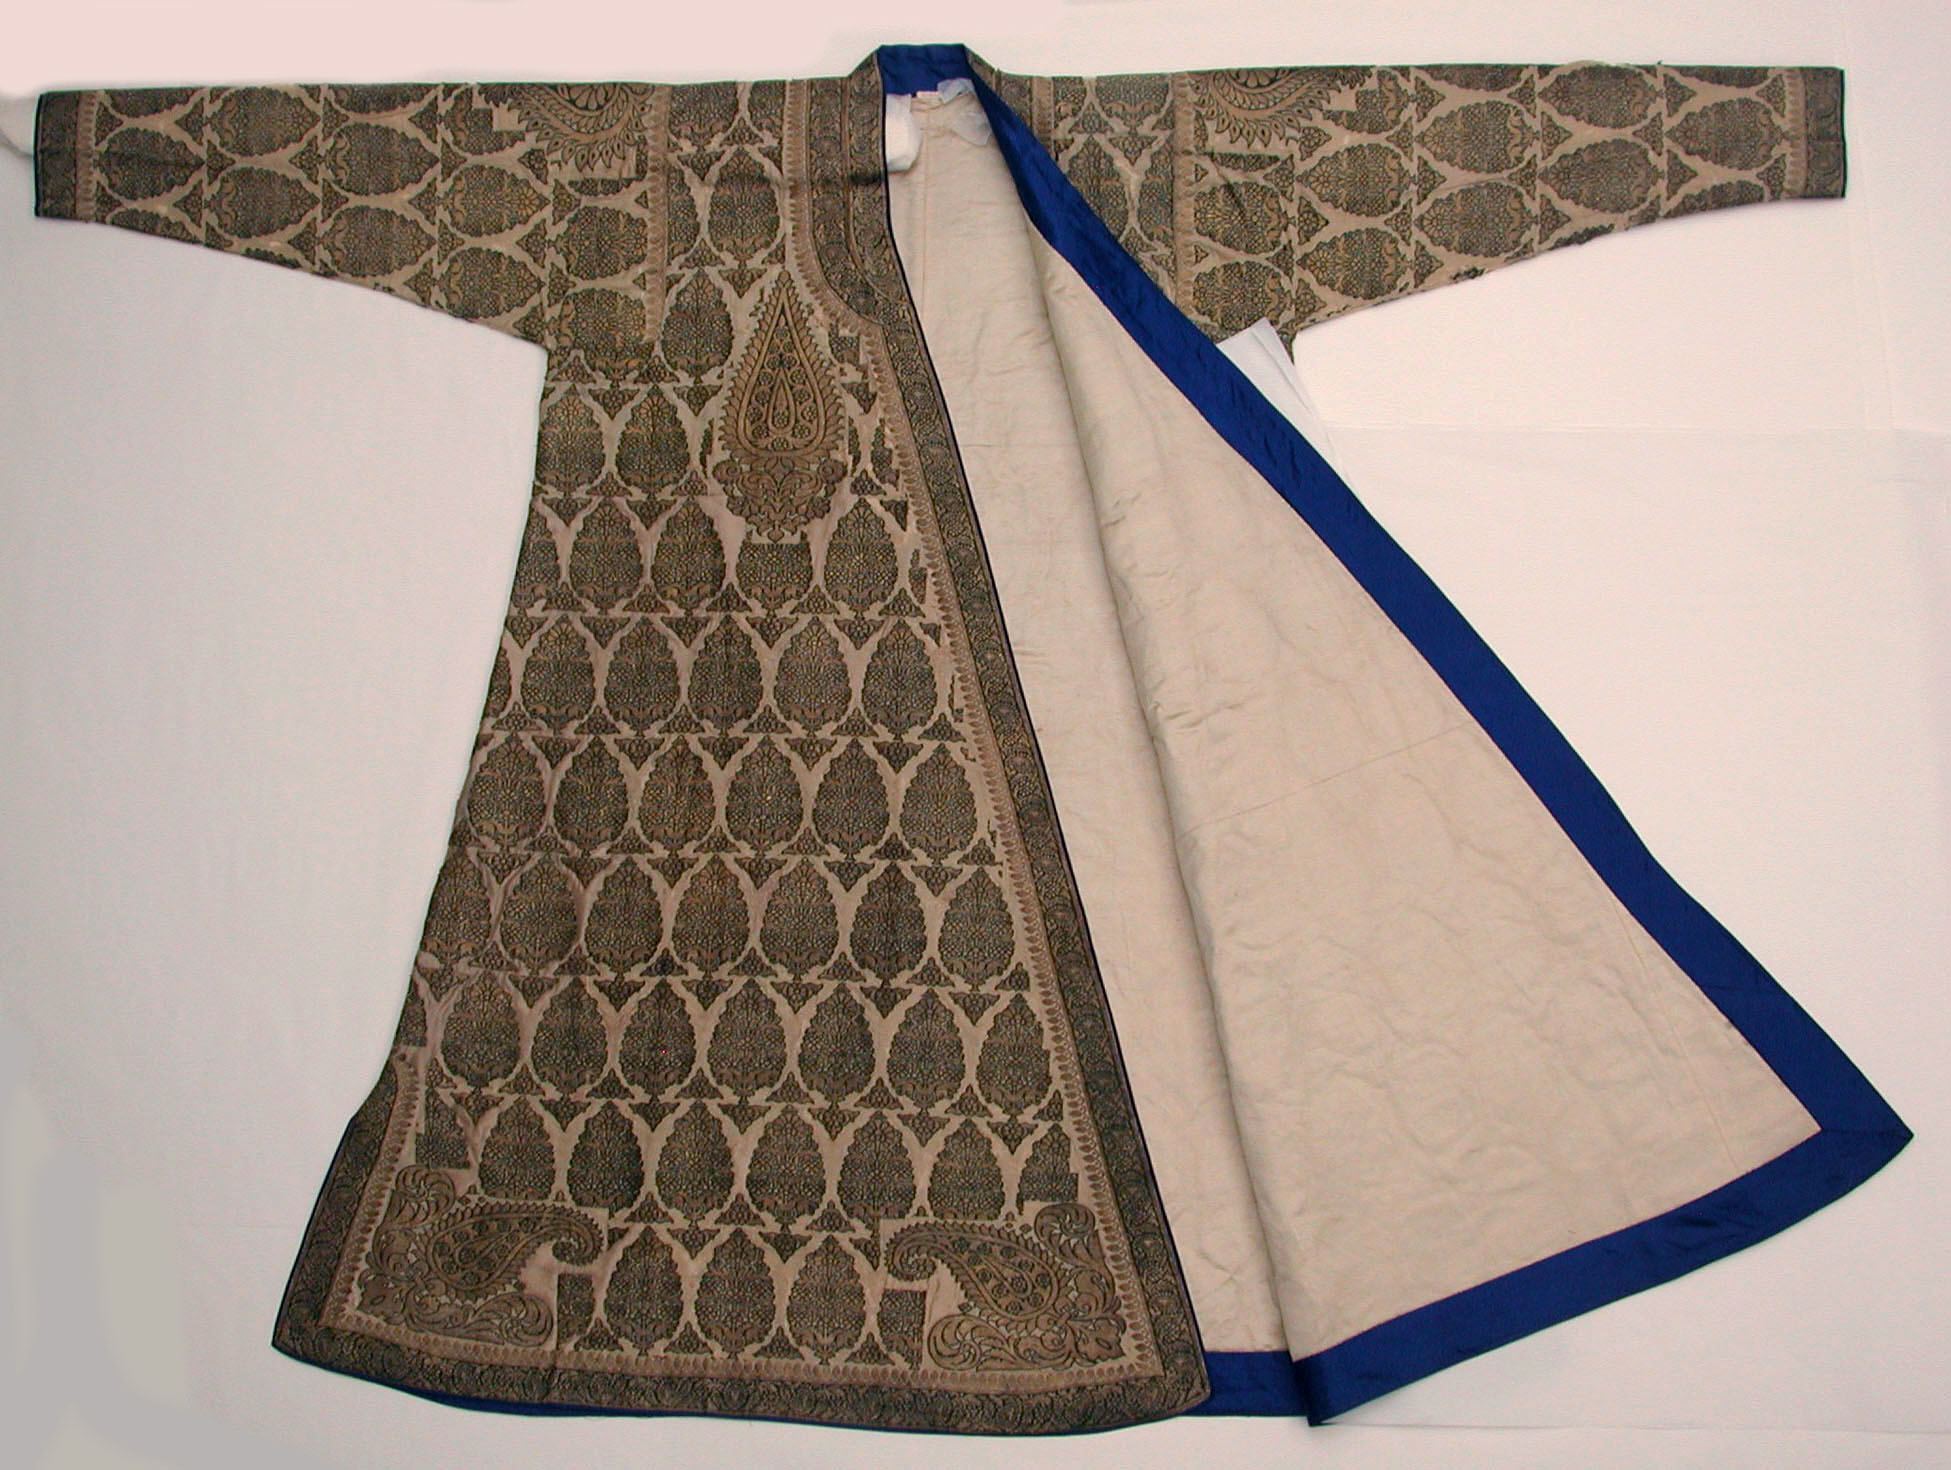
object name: coat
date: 1767-1800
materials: gold, silk, thread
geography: india